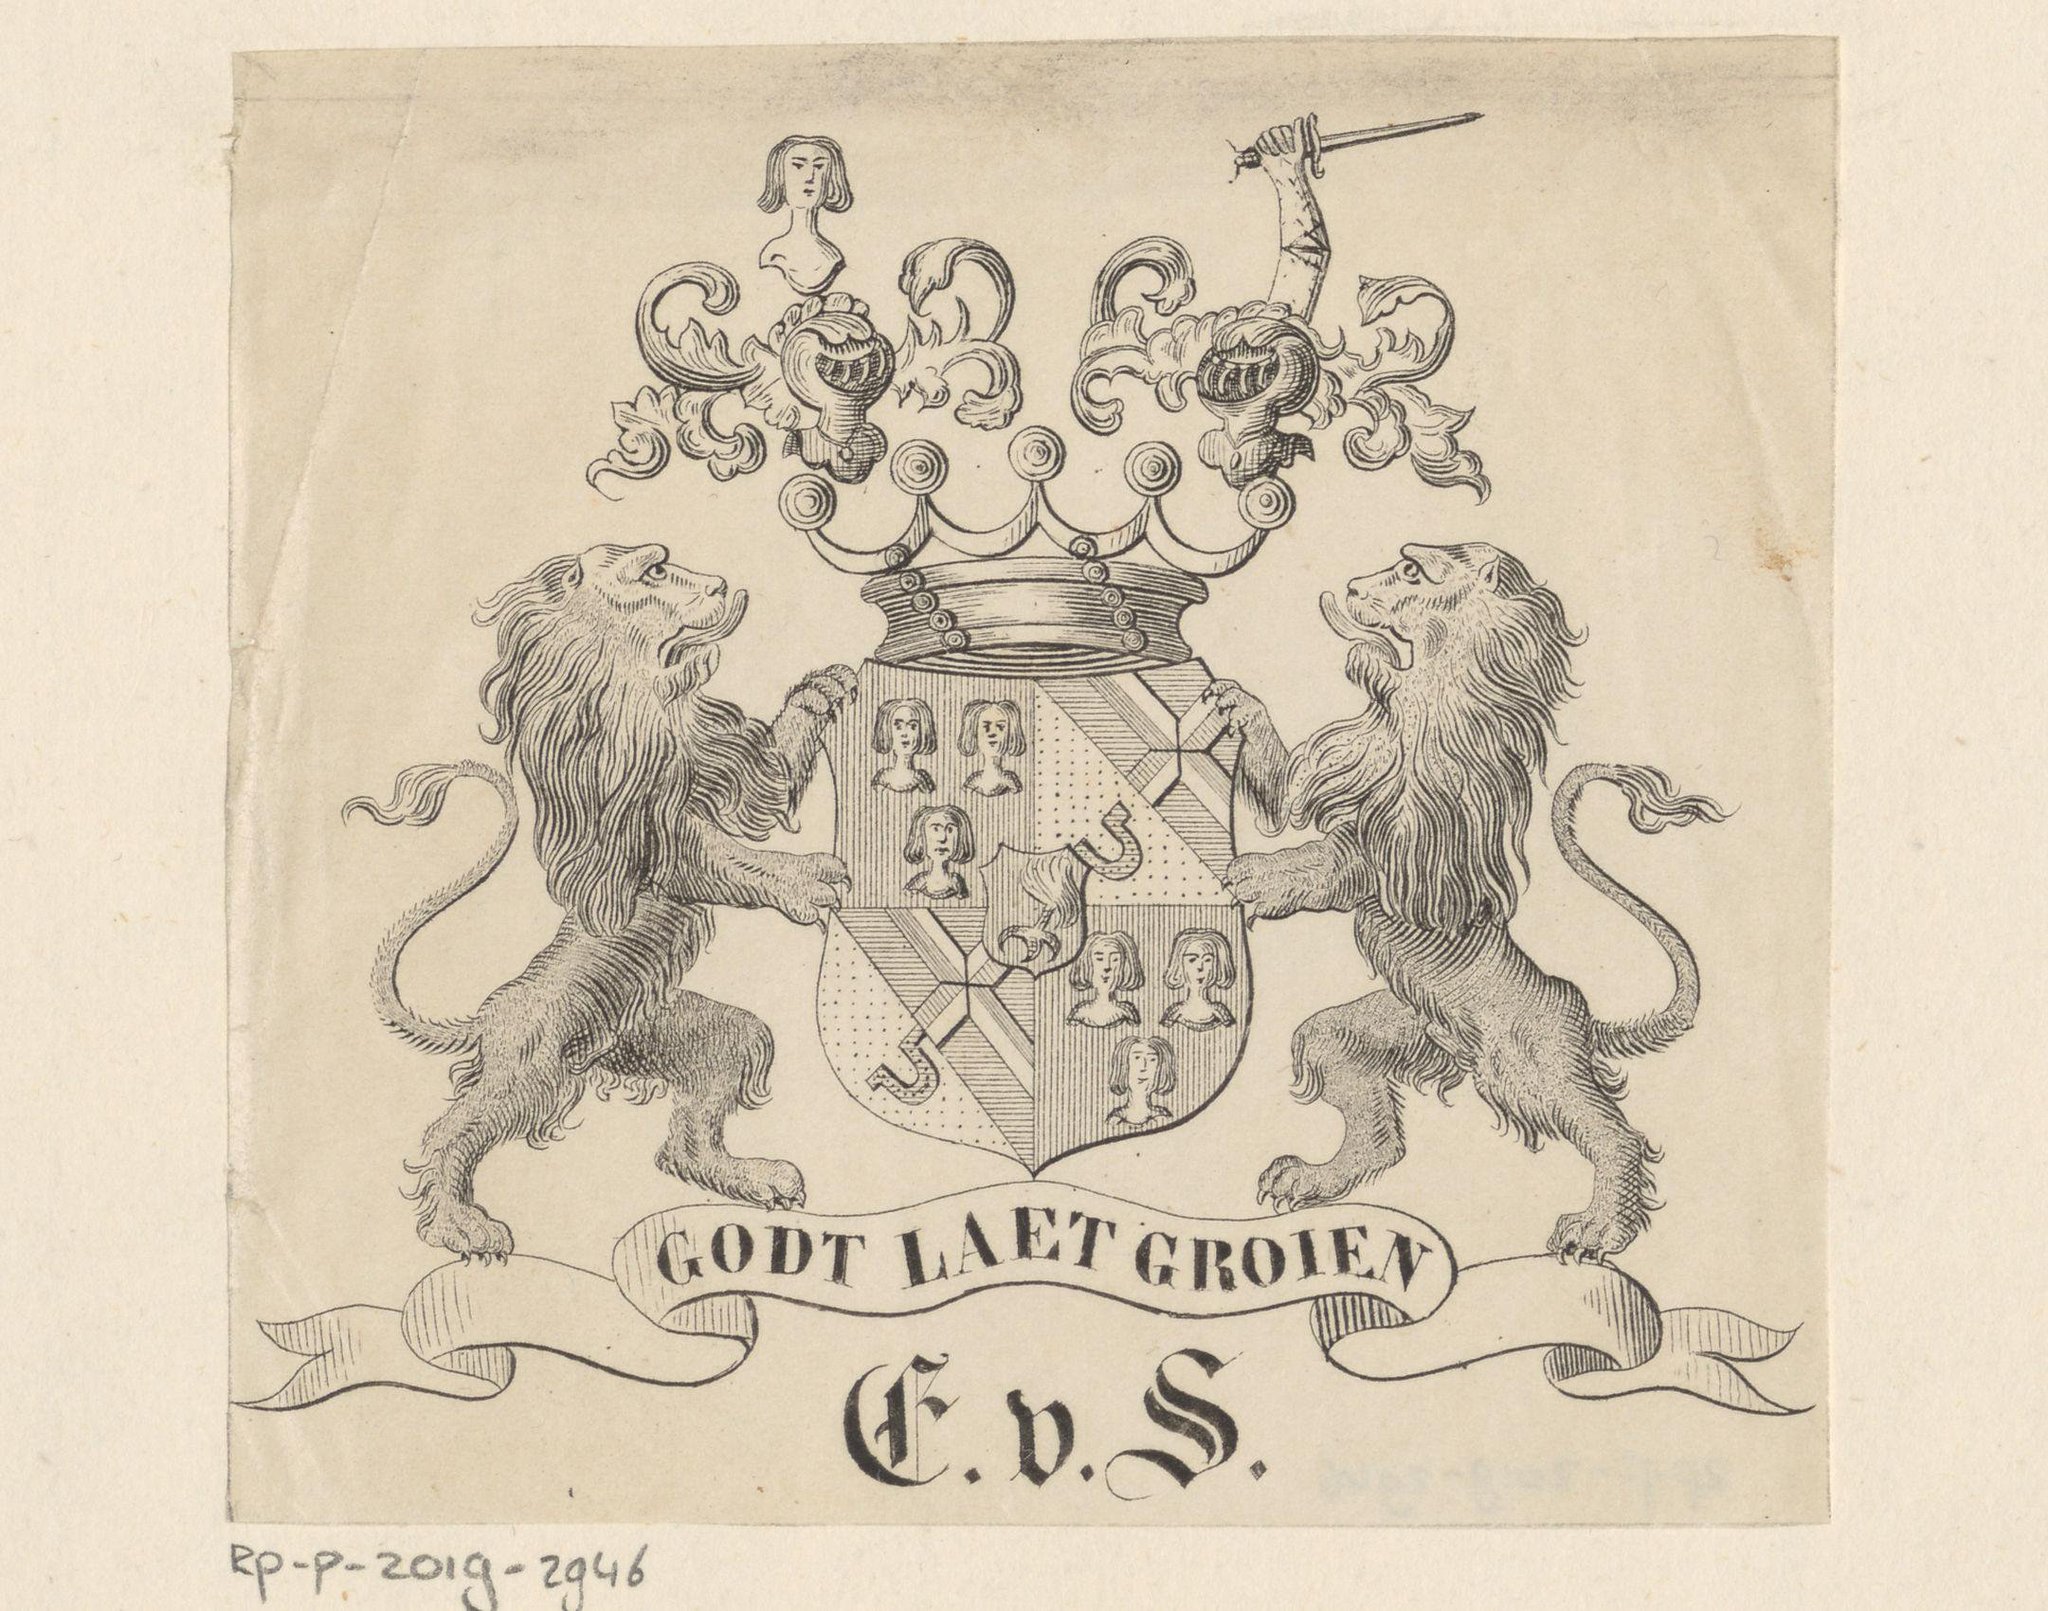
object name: bookplate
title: Godt laet groien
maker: Anonymous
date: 1800-1899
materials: paper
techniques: engraving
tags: armorial bearing, heraldry